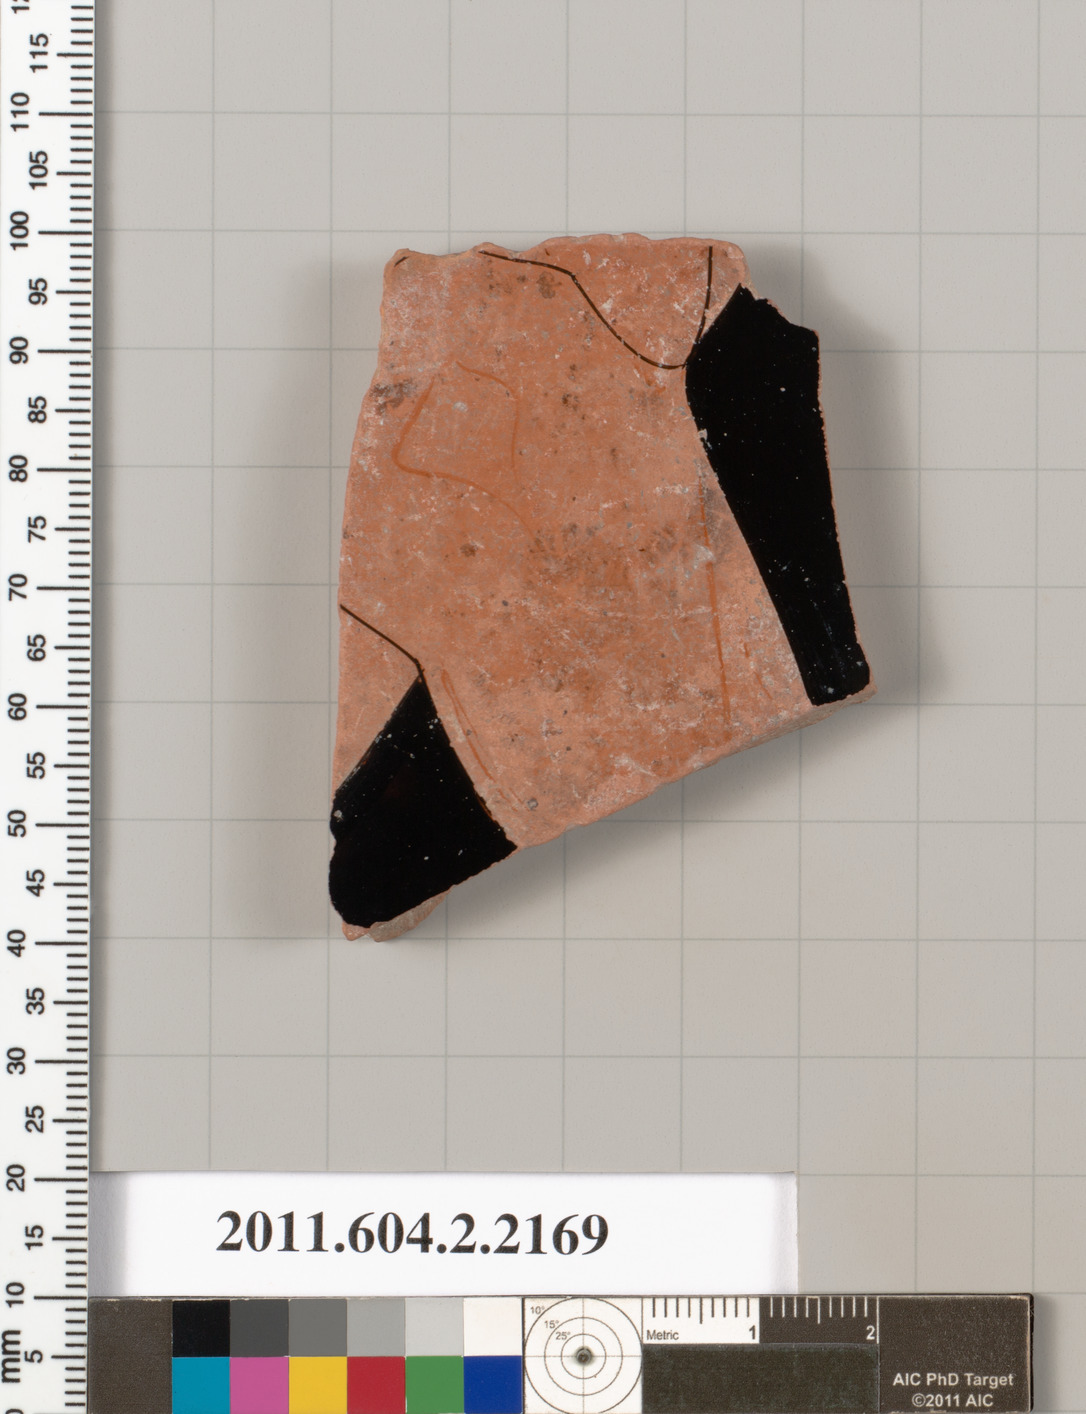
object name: pot fragment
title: Terracotta fragment of a pot; unglazed on the inside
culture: greek, attic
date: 500-480 BCE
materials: terracotta